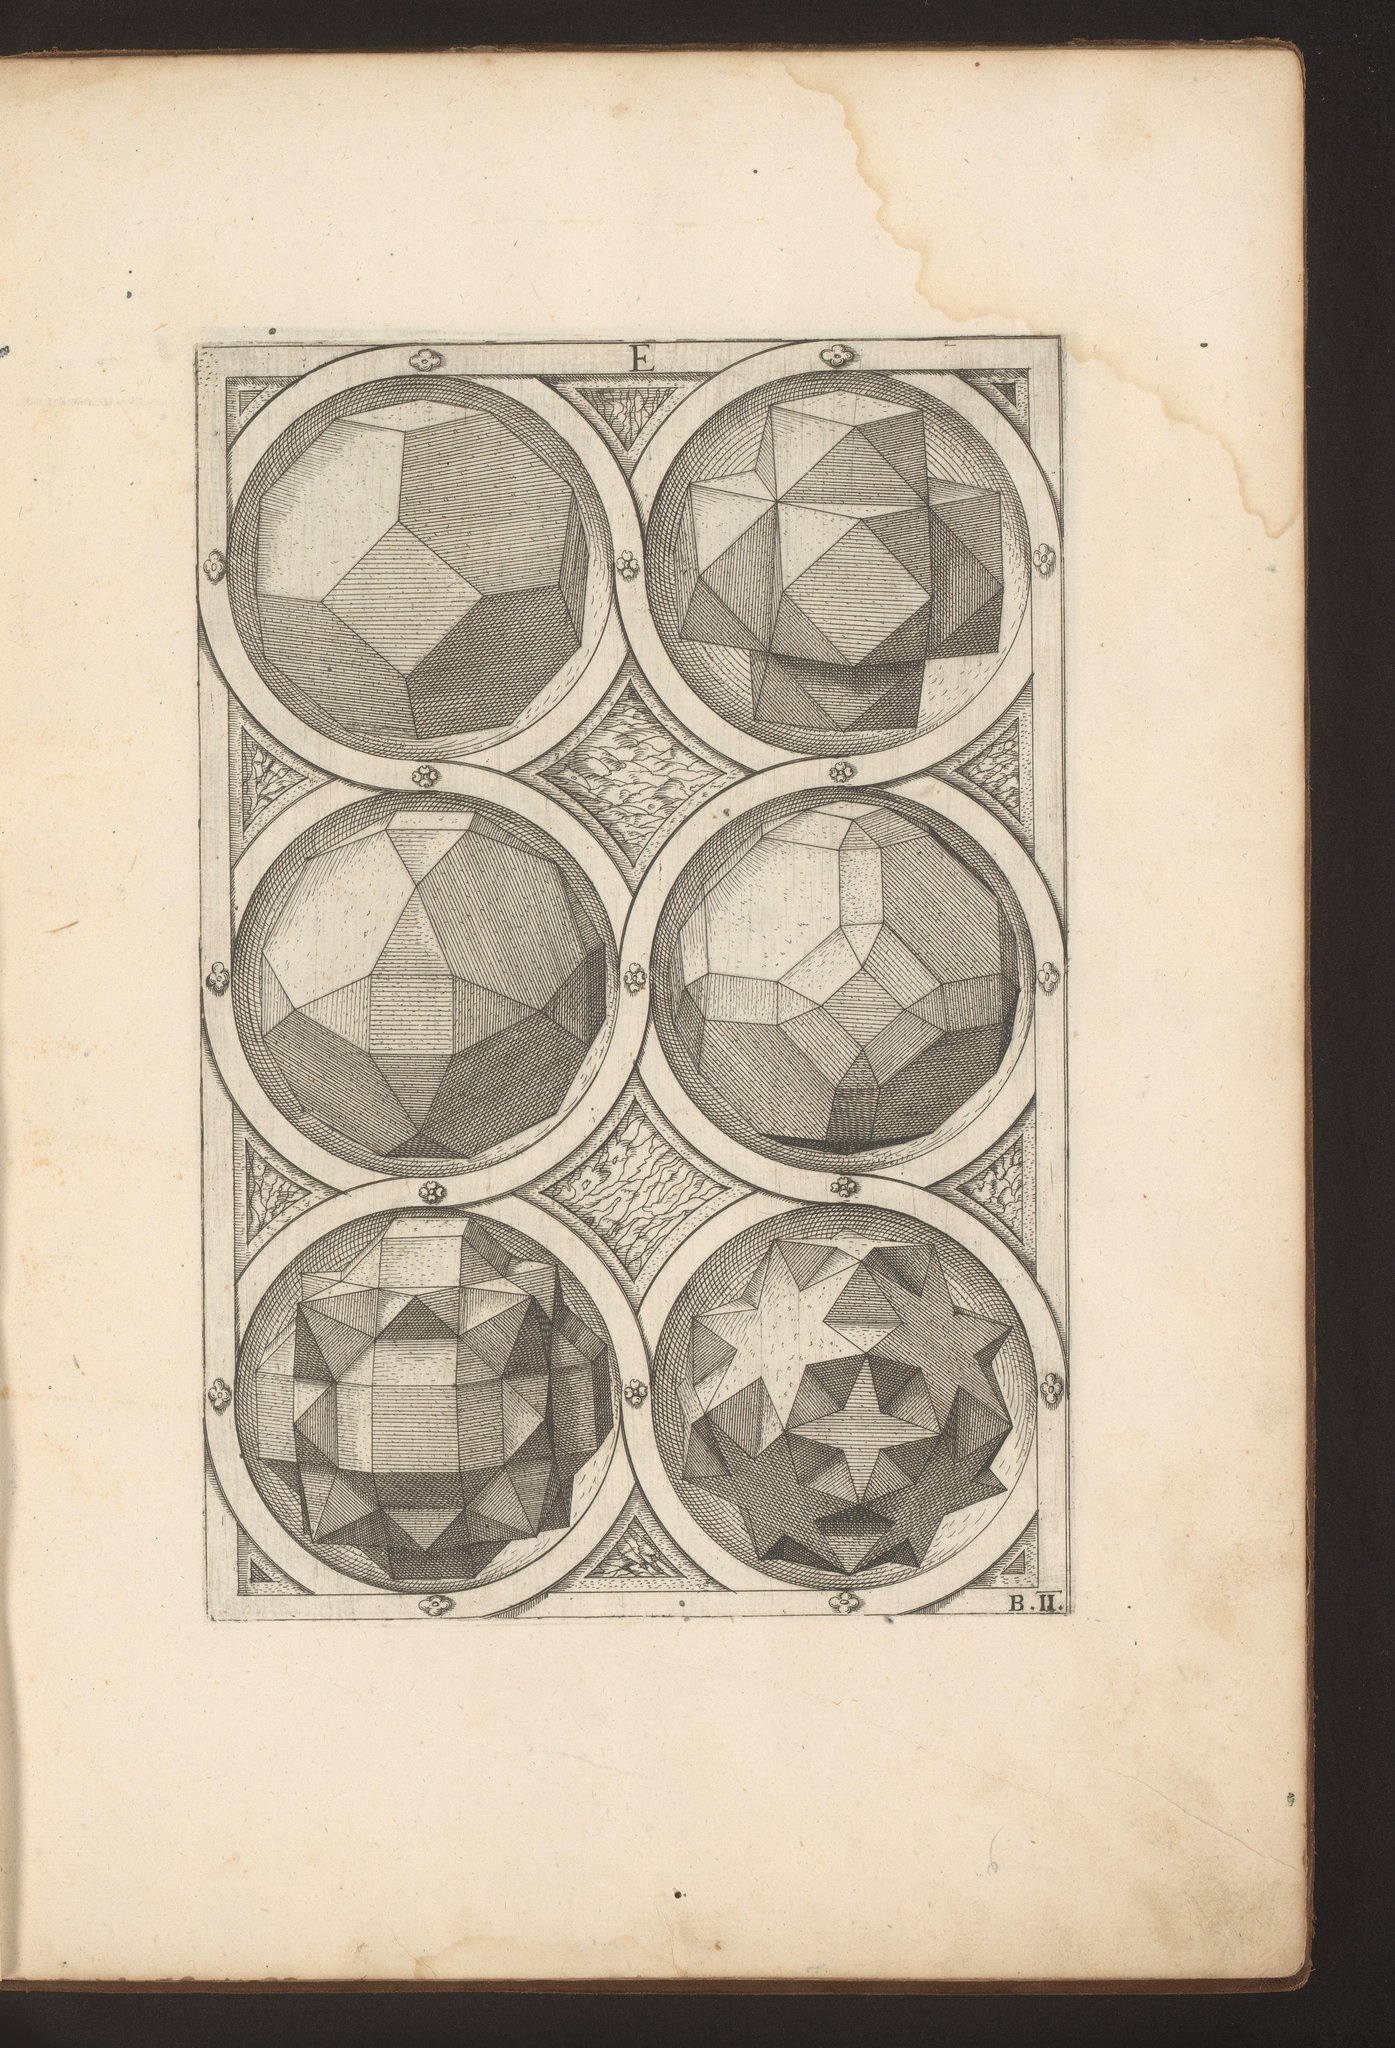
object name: print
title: Zes veelvlakken met een octaëder als uitgangspunt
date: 1568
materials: paper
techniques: etching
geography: nuremberg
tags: other polyhedrons, octahedron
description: De geometrische figuren (polyhedra) worden van boven naar beneden complexer. Rechtsonder genummerd: B.II. Deze prent maakt deel uit van een boek.